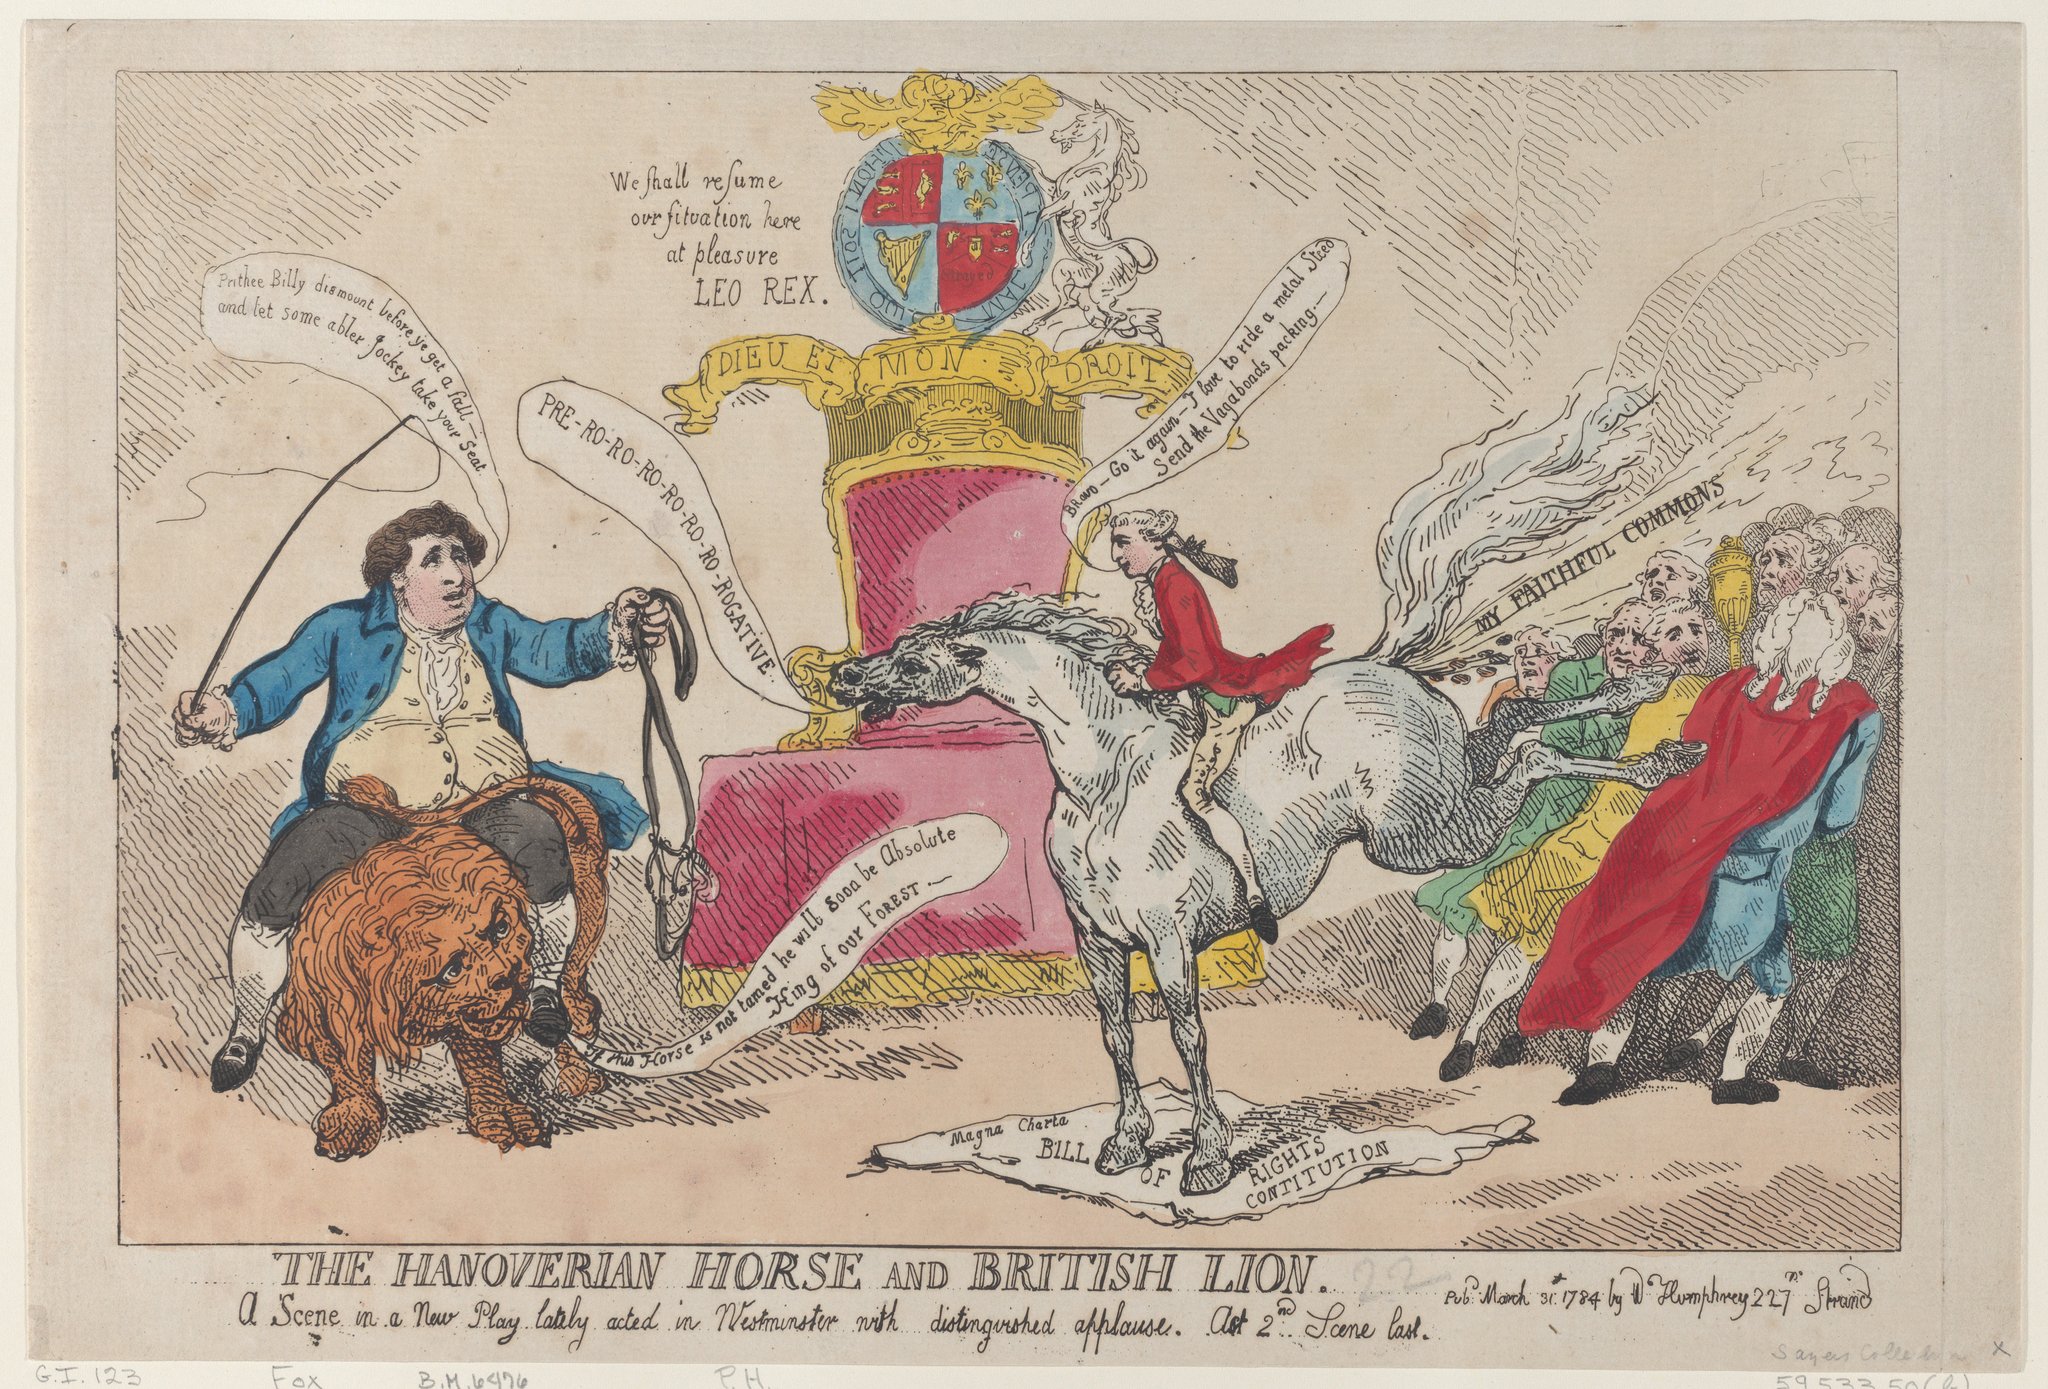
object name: print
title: The Hanoverian Horse and British Lion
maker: thomas rowlandson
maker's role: artist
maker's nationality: british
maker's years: 1757-1827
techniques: etching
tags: satire,men,horses,lions,politics